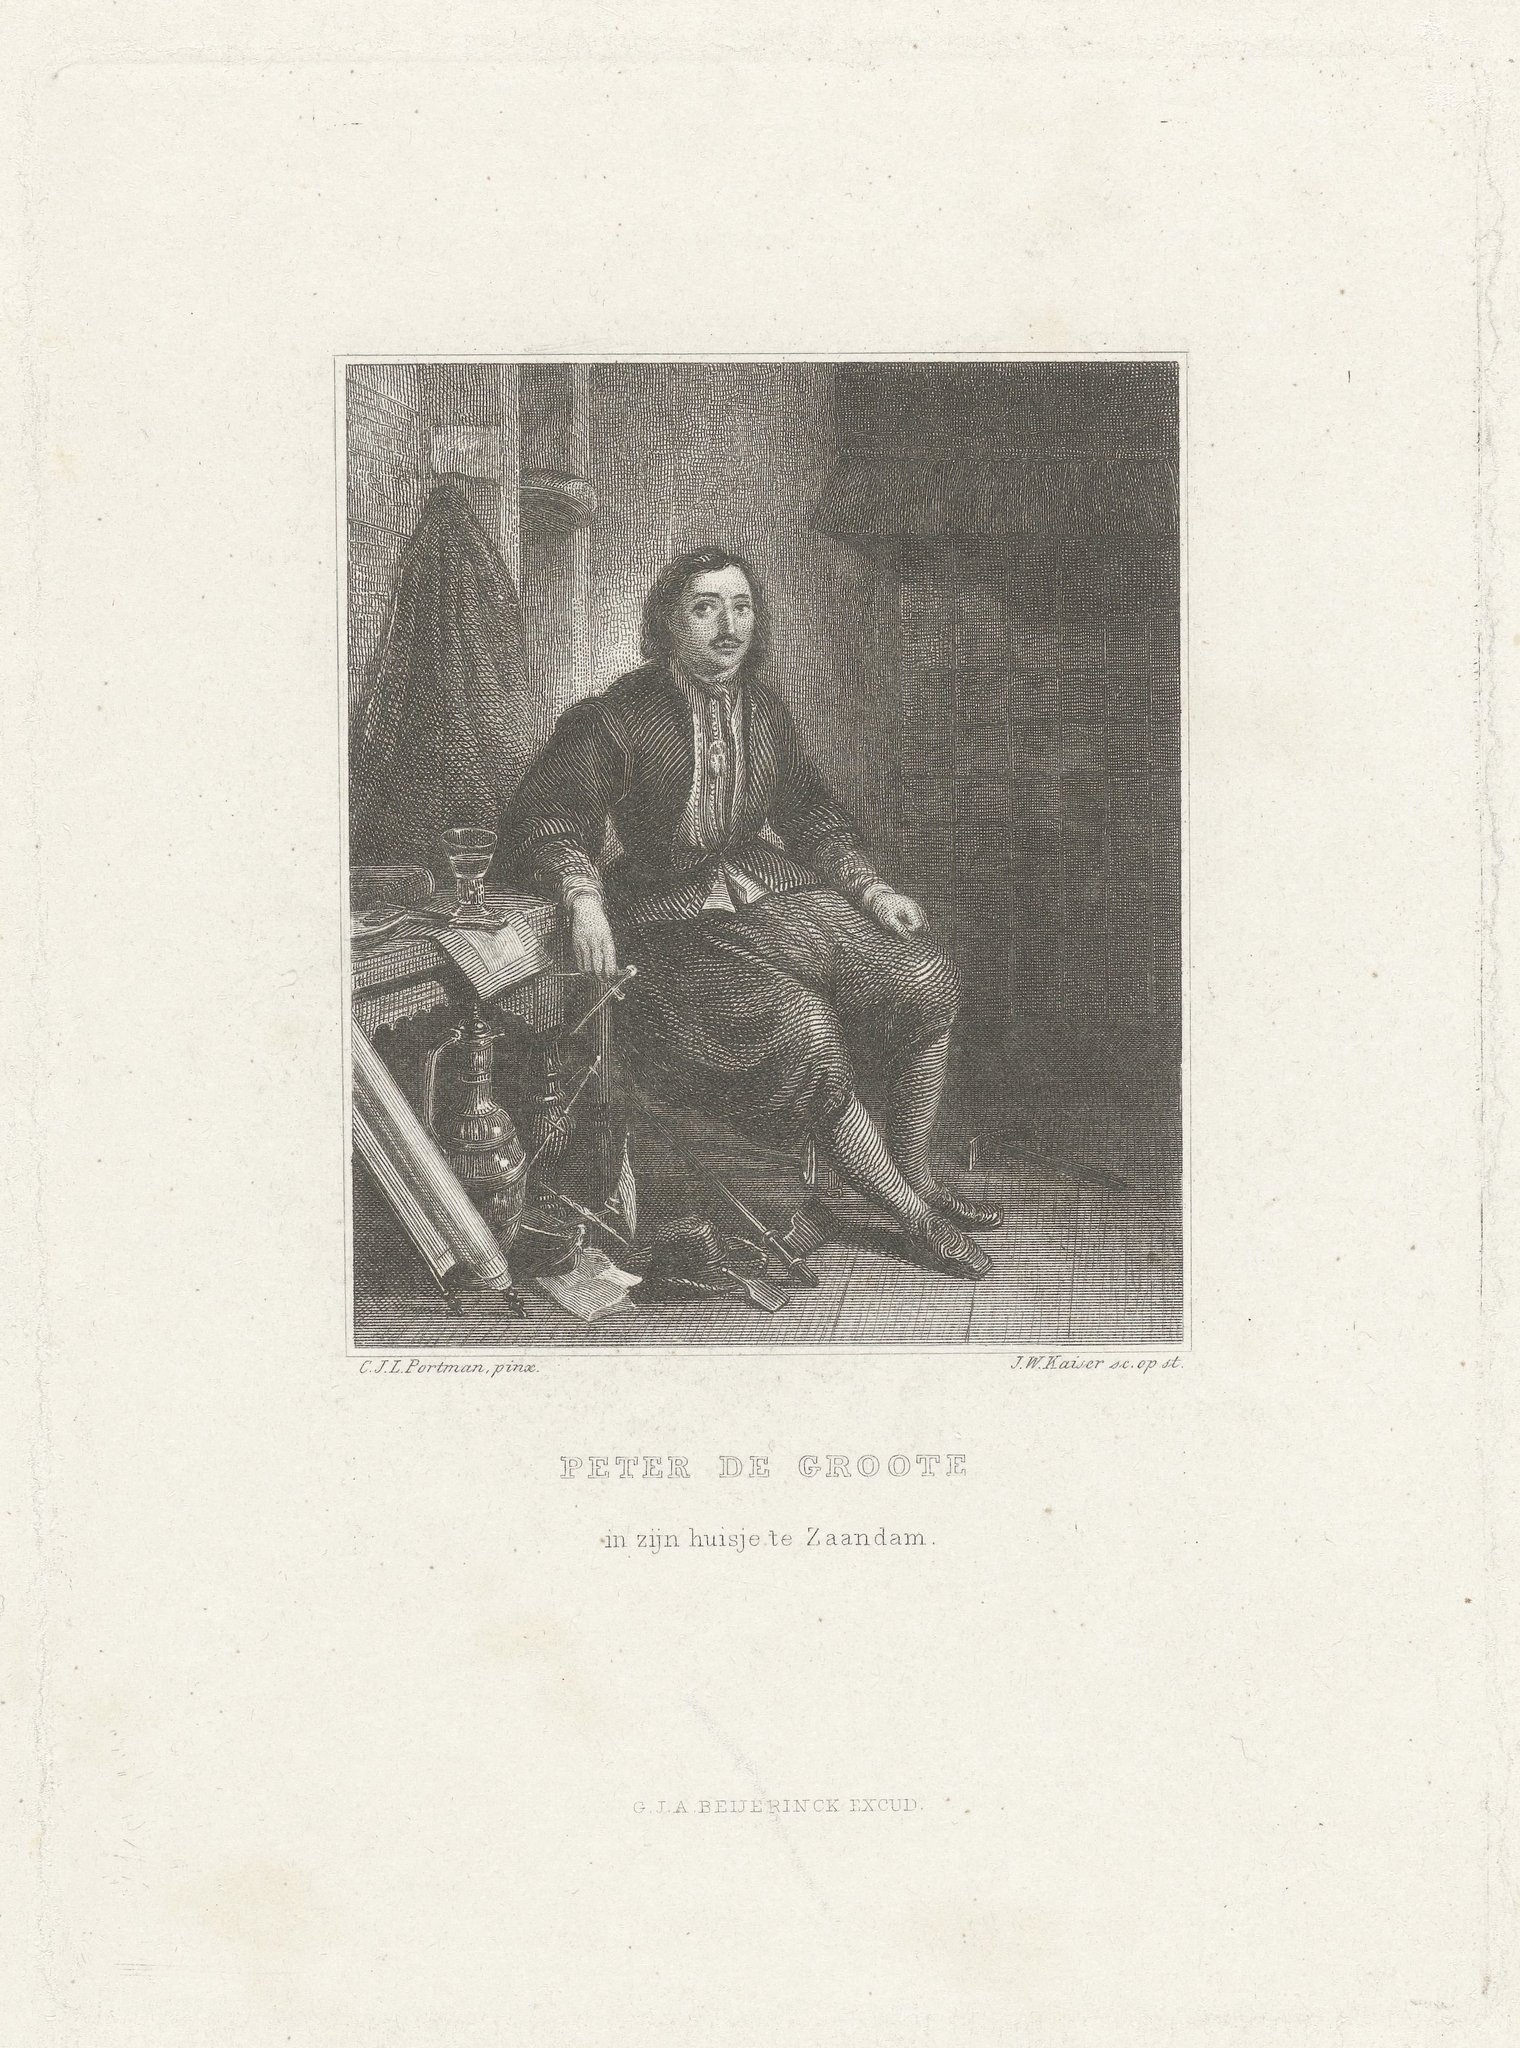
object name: print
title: Peter de Groote en zijn huisje te Zaandam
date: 1823-1900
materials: paper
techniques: etching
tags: zaandam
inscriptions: collector's mark: Lugt 2228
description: Peter de Grote zit in zijn huis in Zaandam bij de schouw. In zijn hand houdt hij een passer en naast hem op tafel staat een halfvol glas.